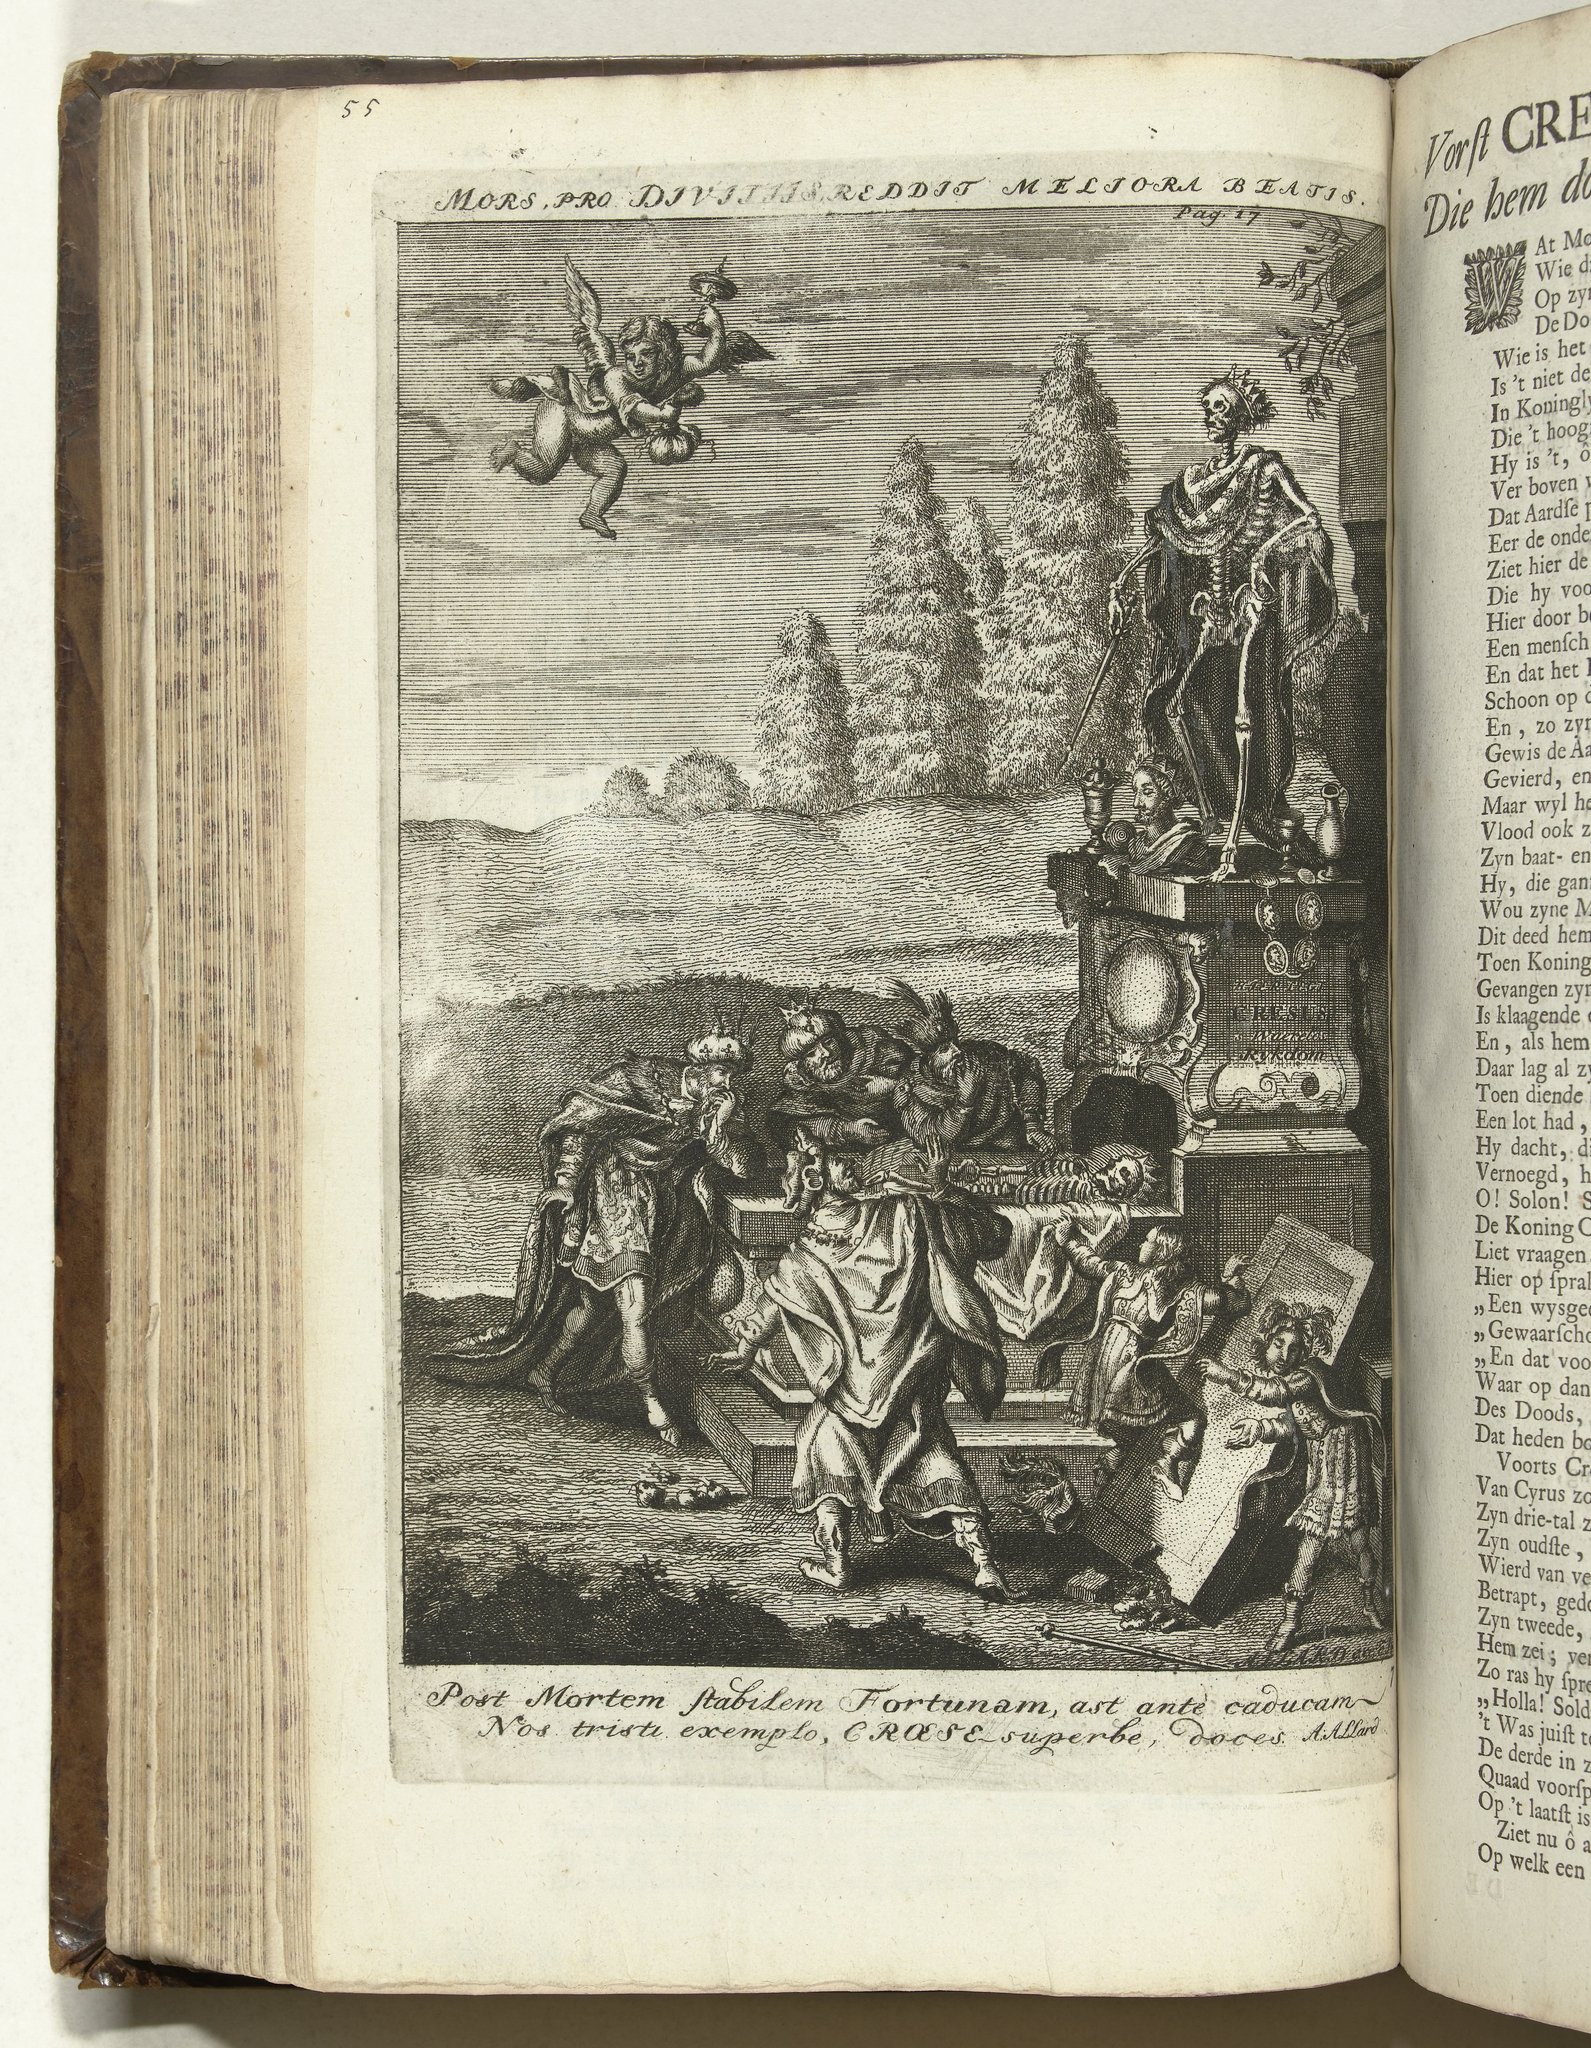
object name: print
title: De Standvastige Monarchye des Doods / 't Lusthof van Momus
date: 1707-1708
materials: paper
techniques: etching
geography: amsterdam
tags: suffering, misfortune of croesus (+ in allegorical or symbolic frame or setting; with allegorical or symbolic accessories), grave, tomb and other grave-forms and grave-markers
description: Allegorie waarin omstanders het geraamte in het geopende graf van koning Croesus bekijken, ca. 1707-1708. Genummerd: 7 en gemerkt: Pag. 17. Onderdeel van: De Standvastige Monarchye des Doods, een reeks van 8 oude platen met verzen aangepast voor gebruik als spotprenten op de Fransen in de context van de Spaanse Successieoorlog. Onderdeel van het prentwerk uitgegeven onder de verzameltitel 't Lust-Hof van Momus met de gebundelde series van spotprenten tijdens de jaren 1701-1713 van de Spaanse Successieoorlog.